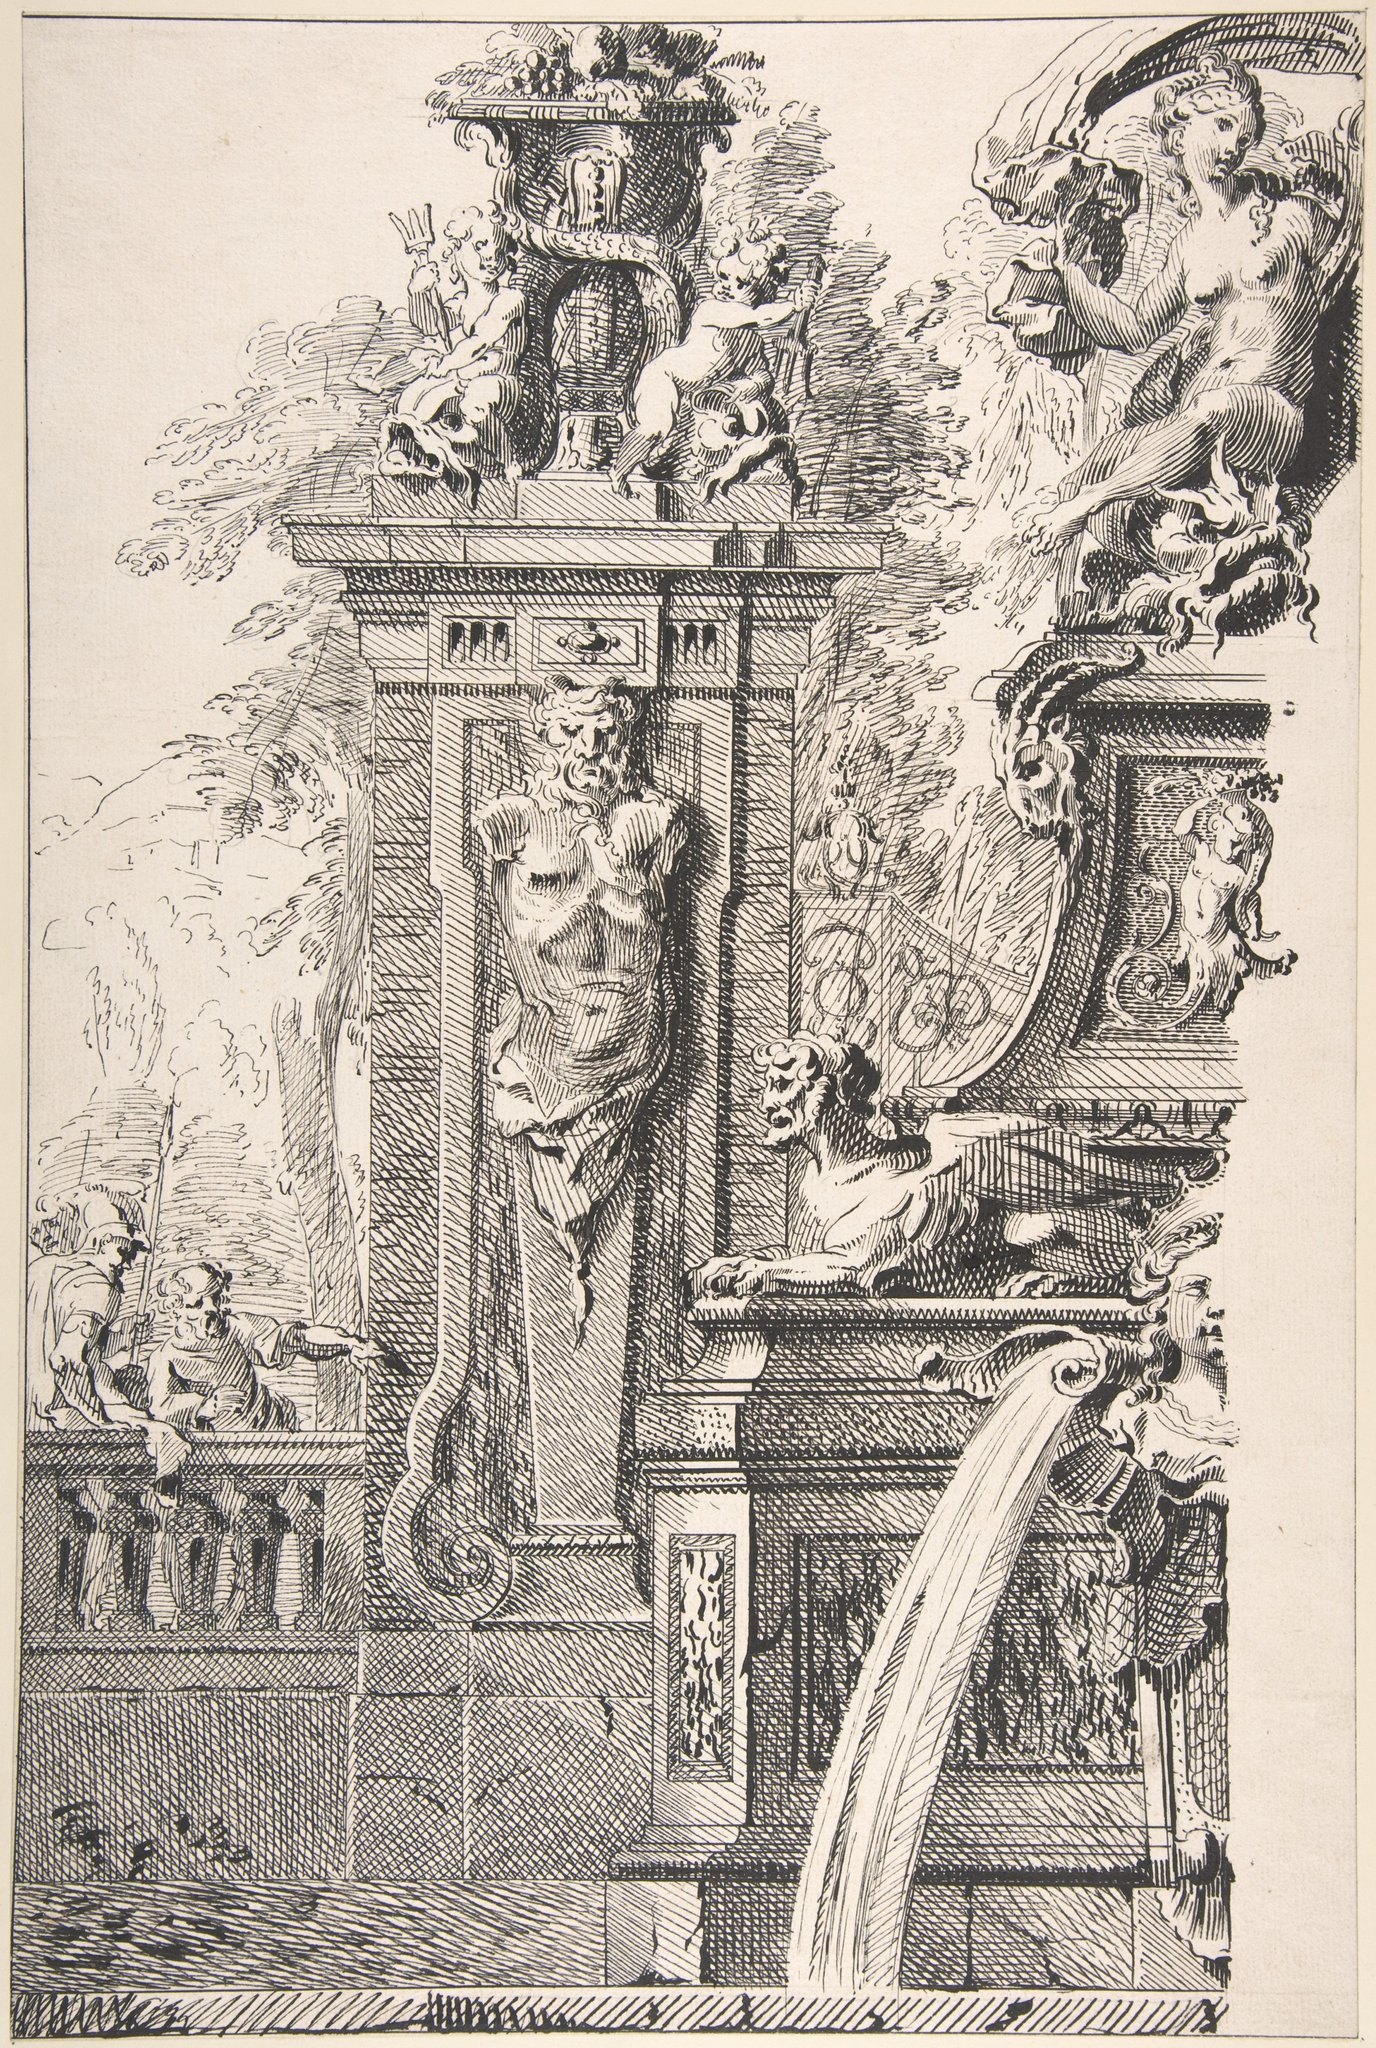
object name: drawing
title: Study for a Garden Capriccio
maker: gilles-marie oppenord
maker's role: artist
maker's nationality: french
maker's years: 1672-1742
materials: graphite, ink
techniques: pen, drawing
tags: human figures,gardens